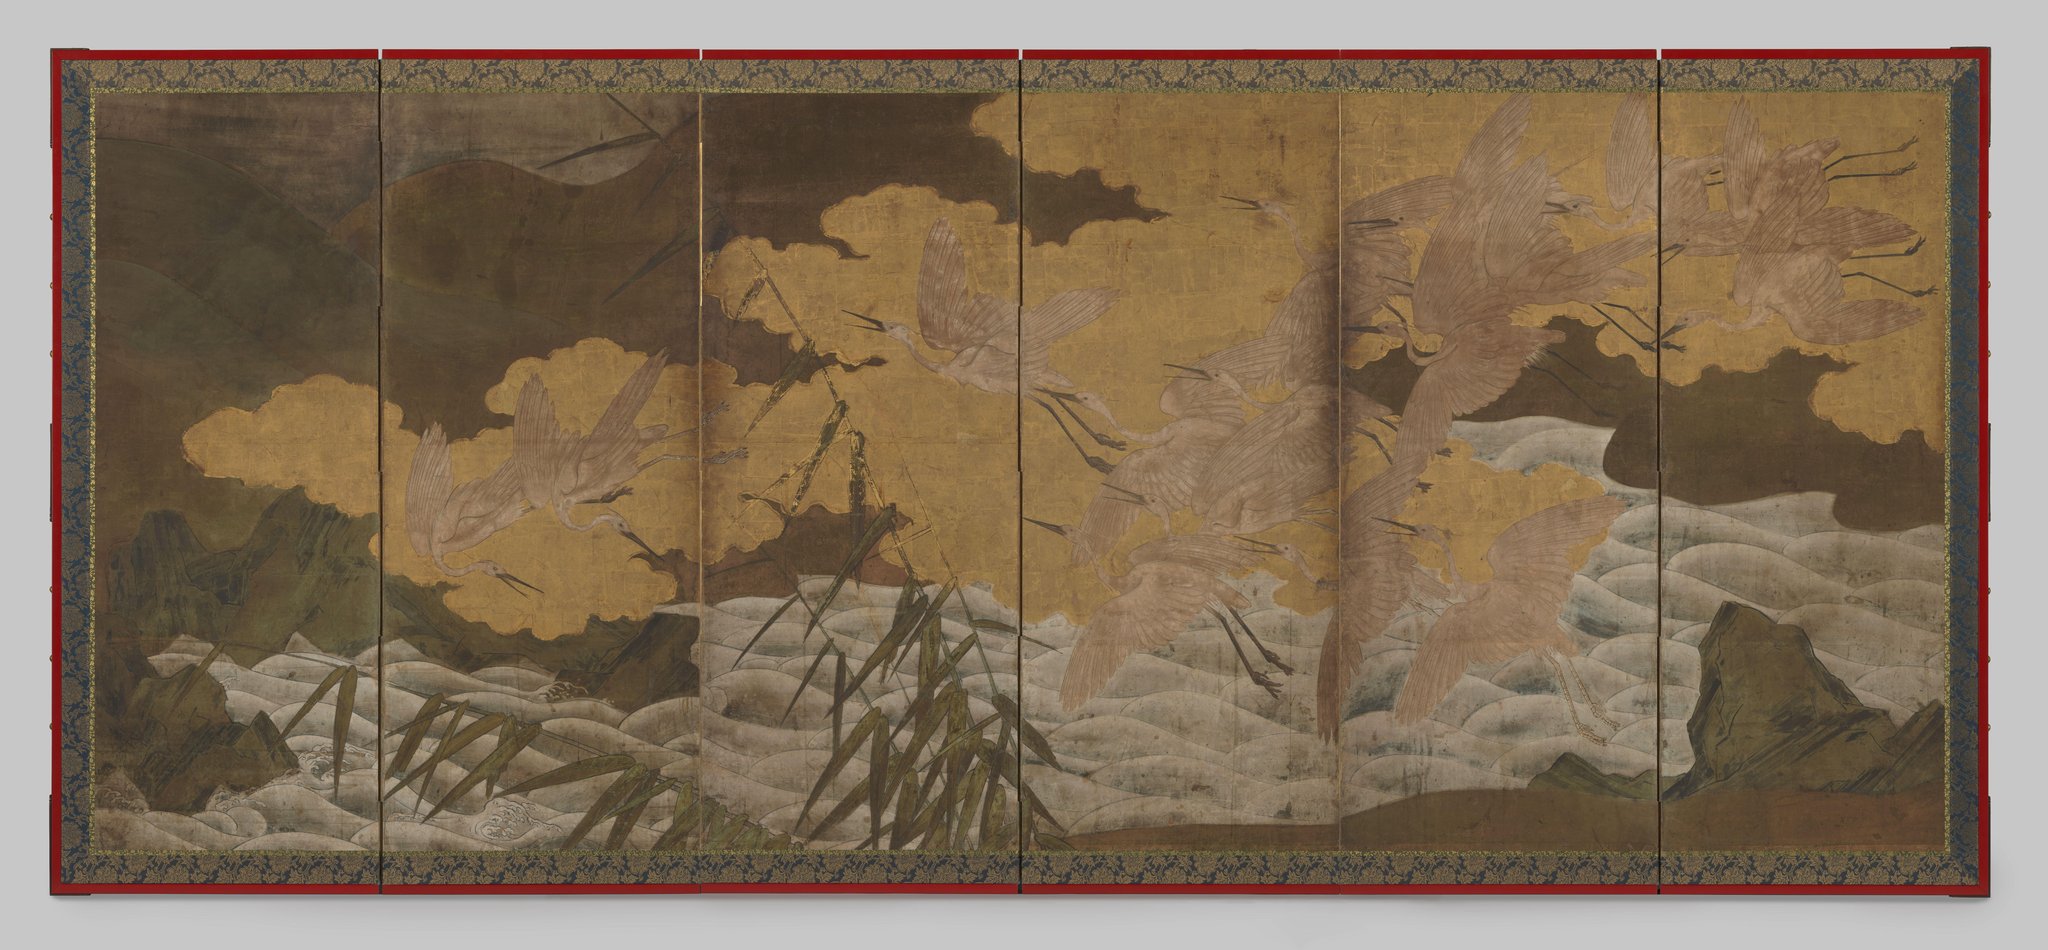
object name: vouwscherm, kamerscherm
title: Egrets in Flight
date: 1600-1700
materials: gold, ink, lacquer, paper, pigment, silk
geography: japan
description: A flight of small egrets occupies the full width of this pair of folding screens. There is movement everywhere, from the dynamic waves to the stylized clouds in gold leaf, most of which serve as backdrops for the birds. Thanks to generous financial support these screens were recently restored. The paintings were cleaned, re-stretched and fitted with a new silk frame.